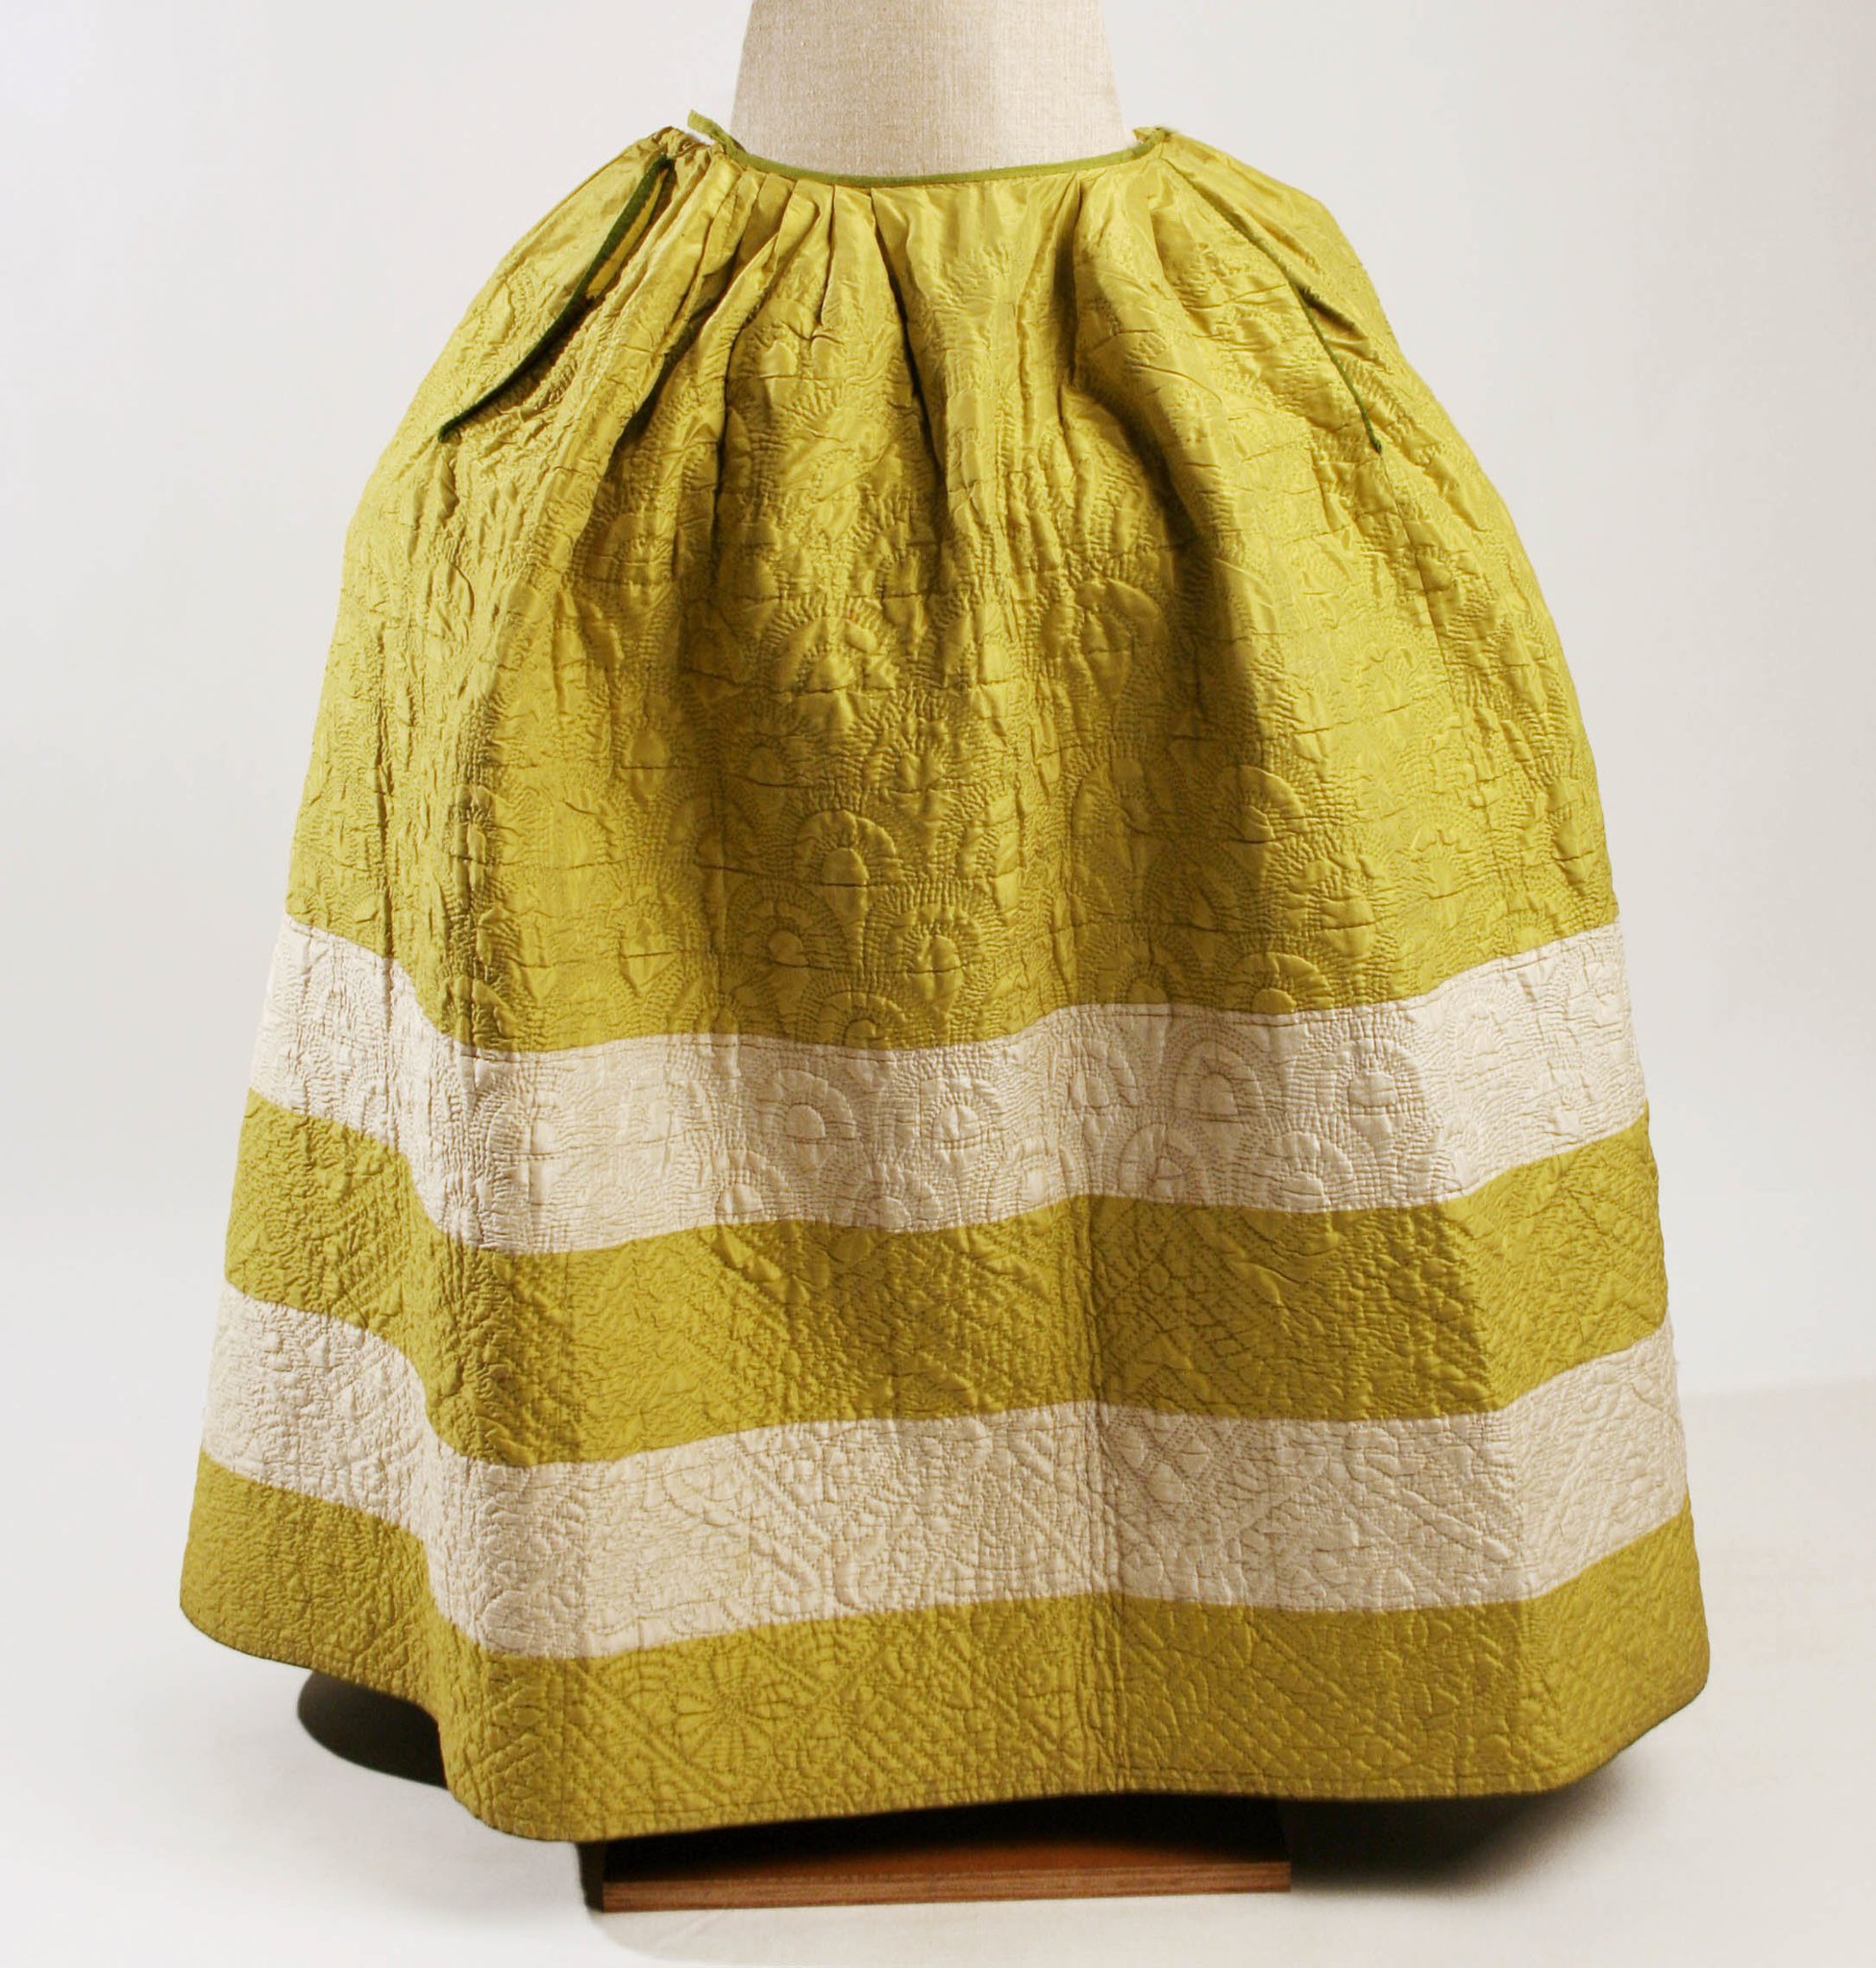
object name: petticoat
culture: british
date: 1734-1766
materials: silk